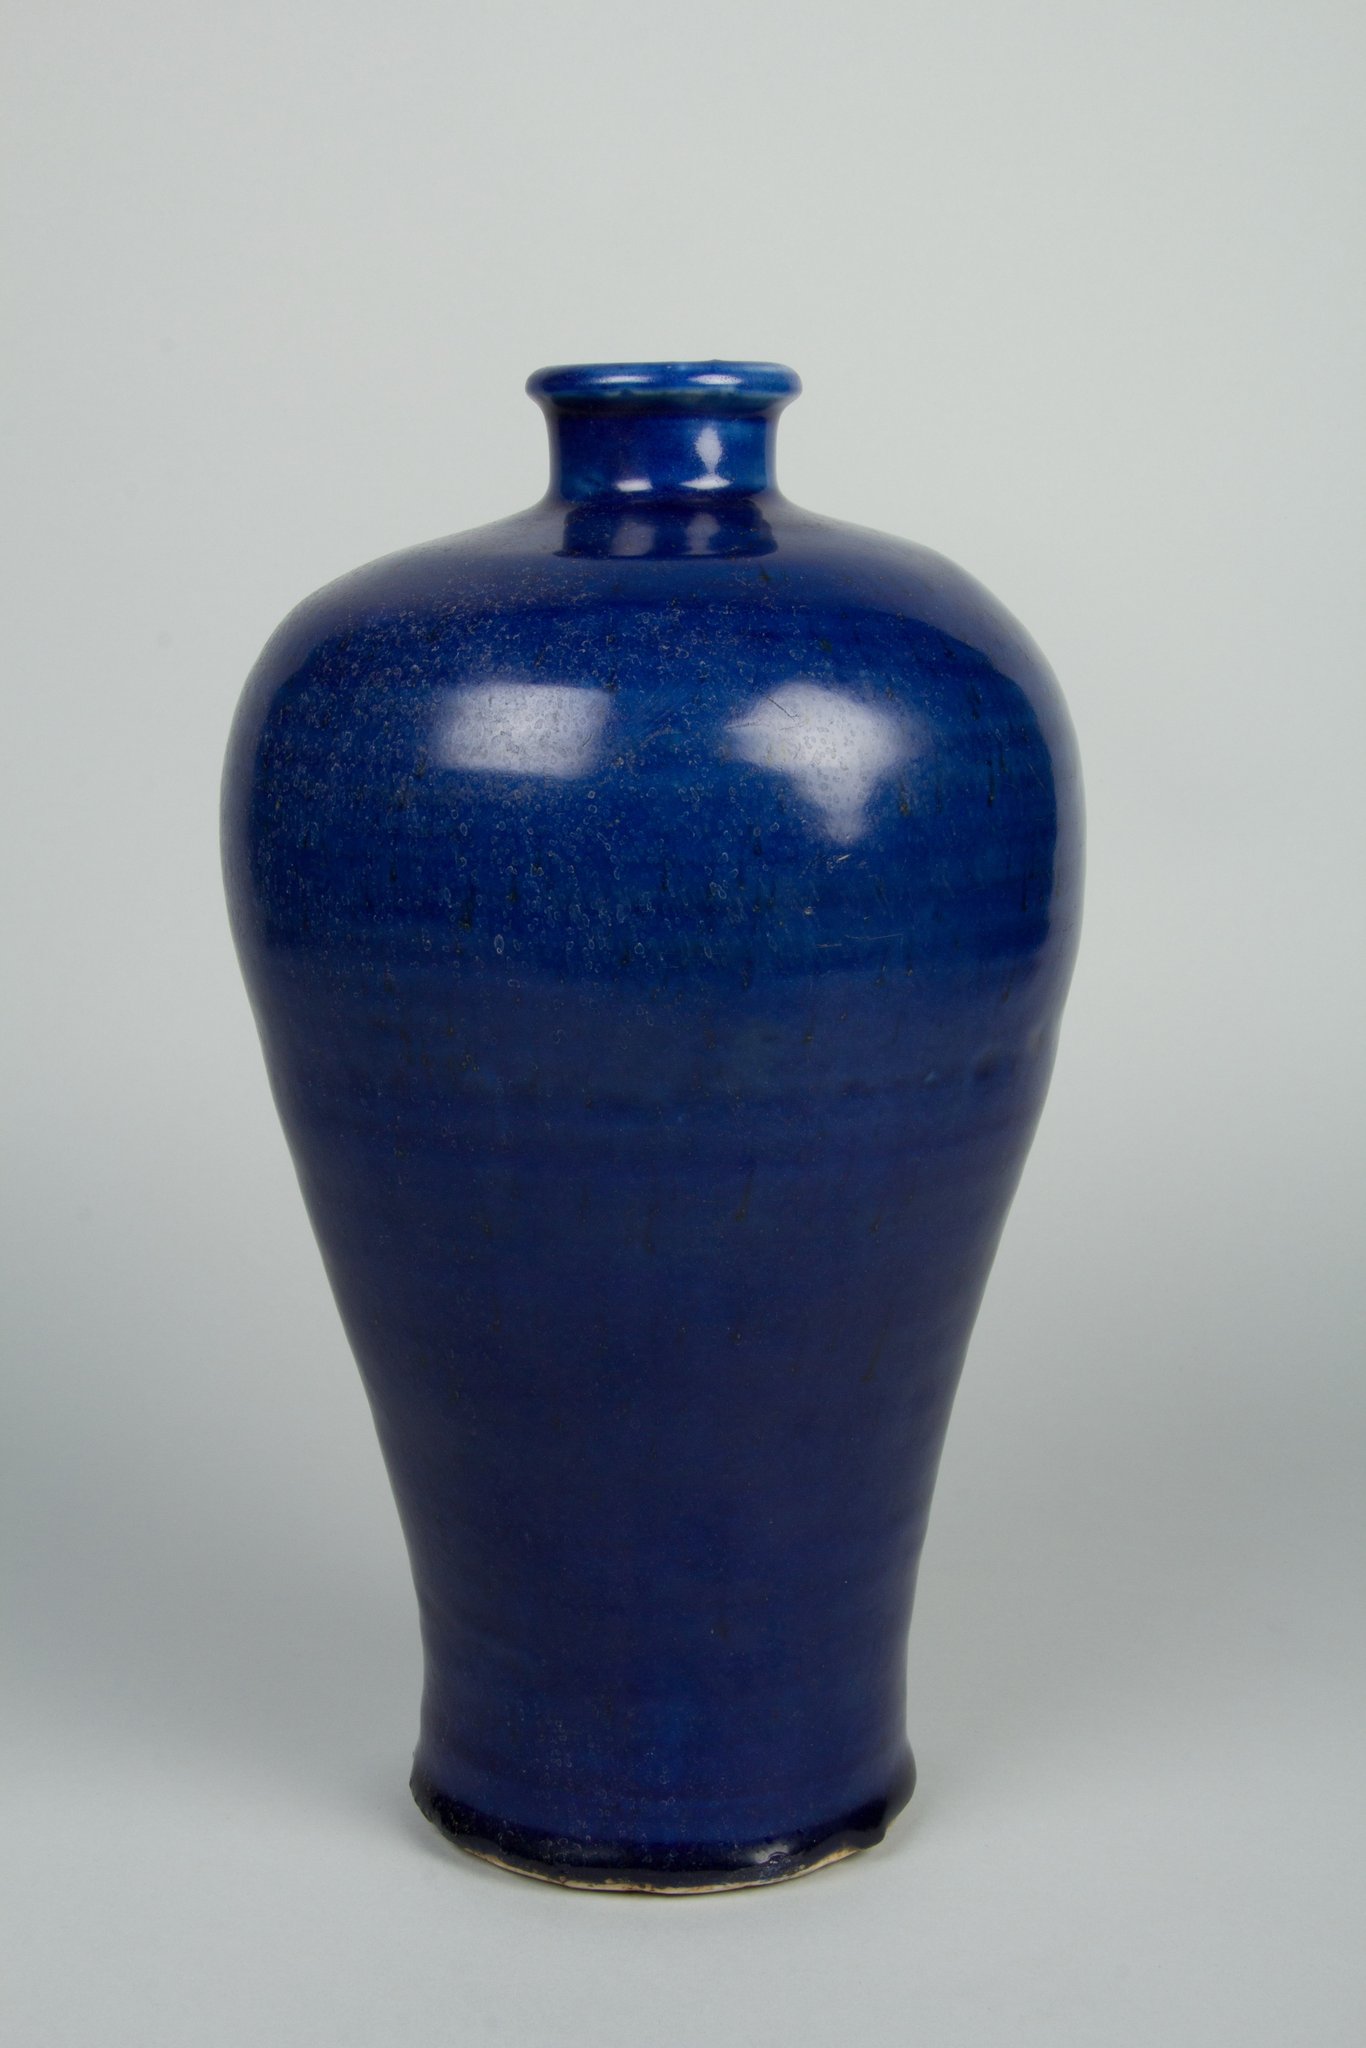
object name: vase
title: Meiping Vase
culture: chinese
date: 1401-1433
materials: glaze, porcelain